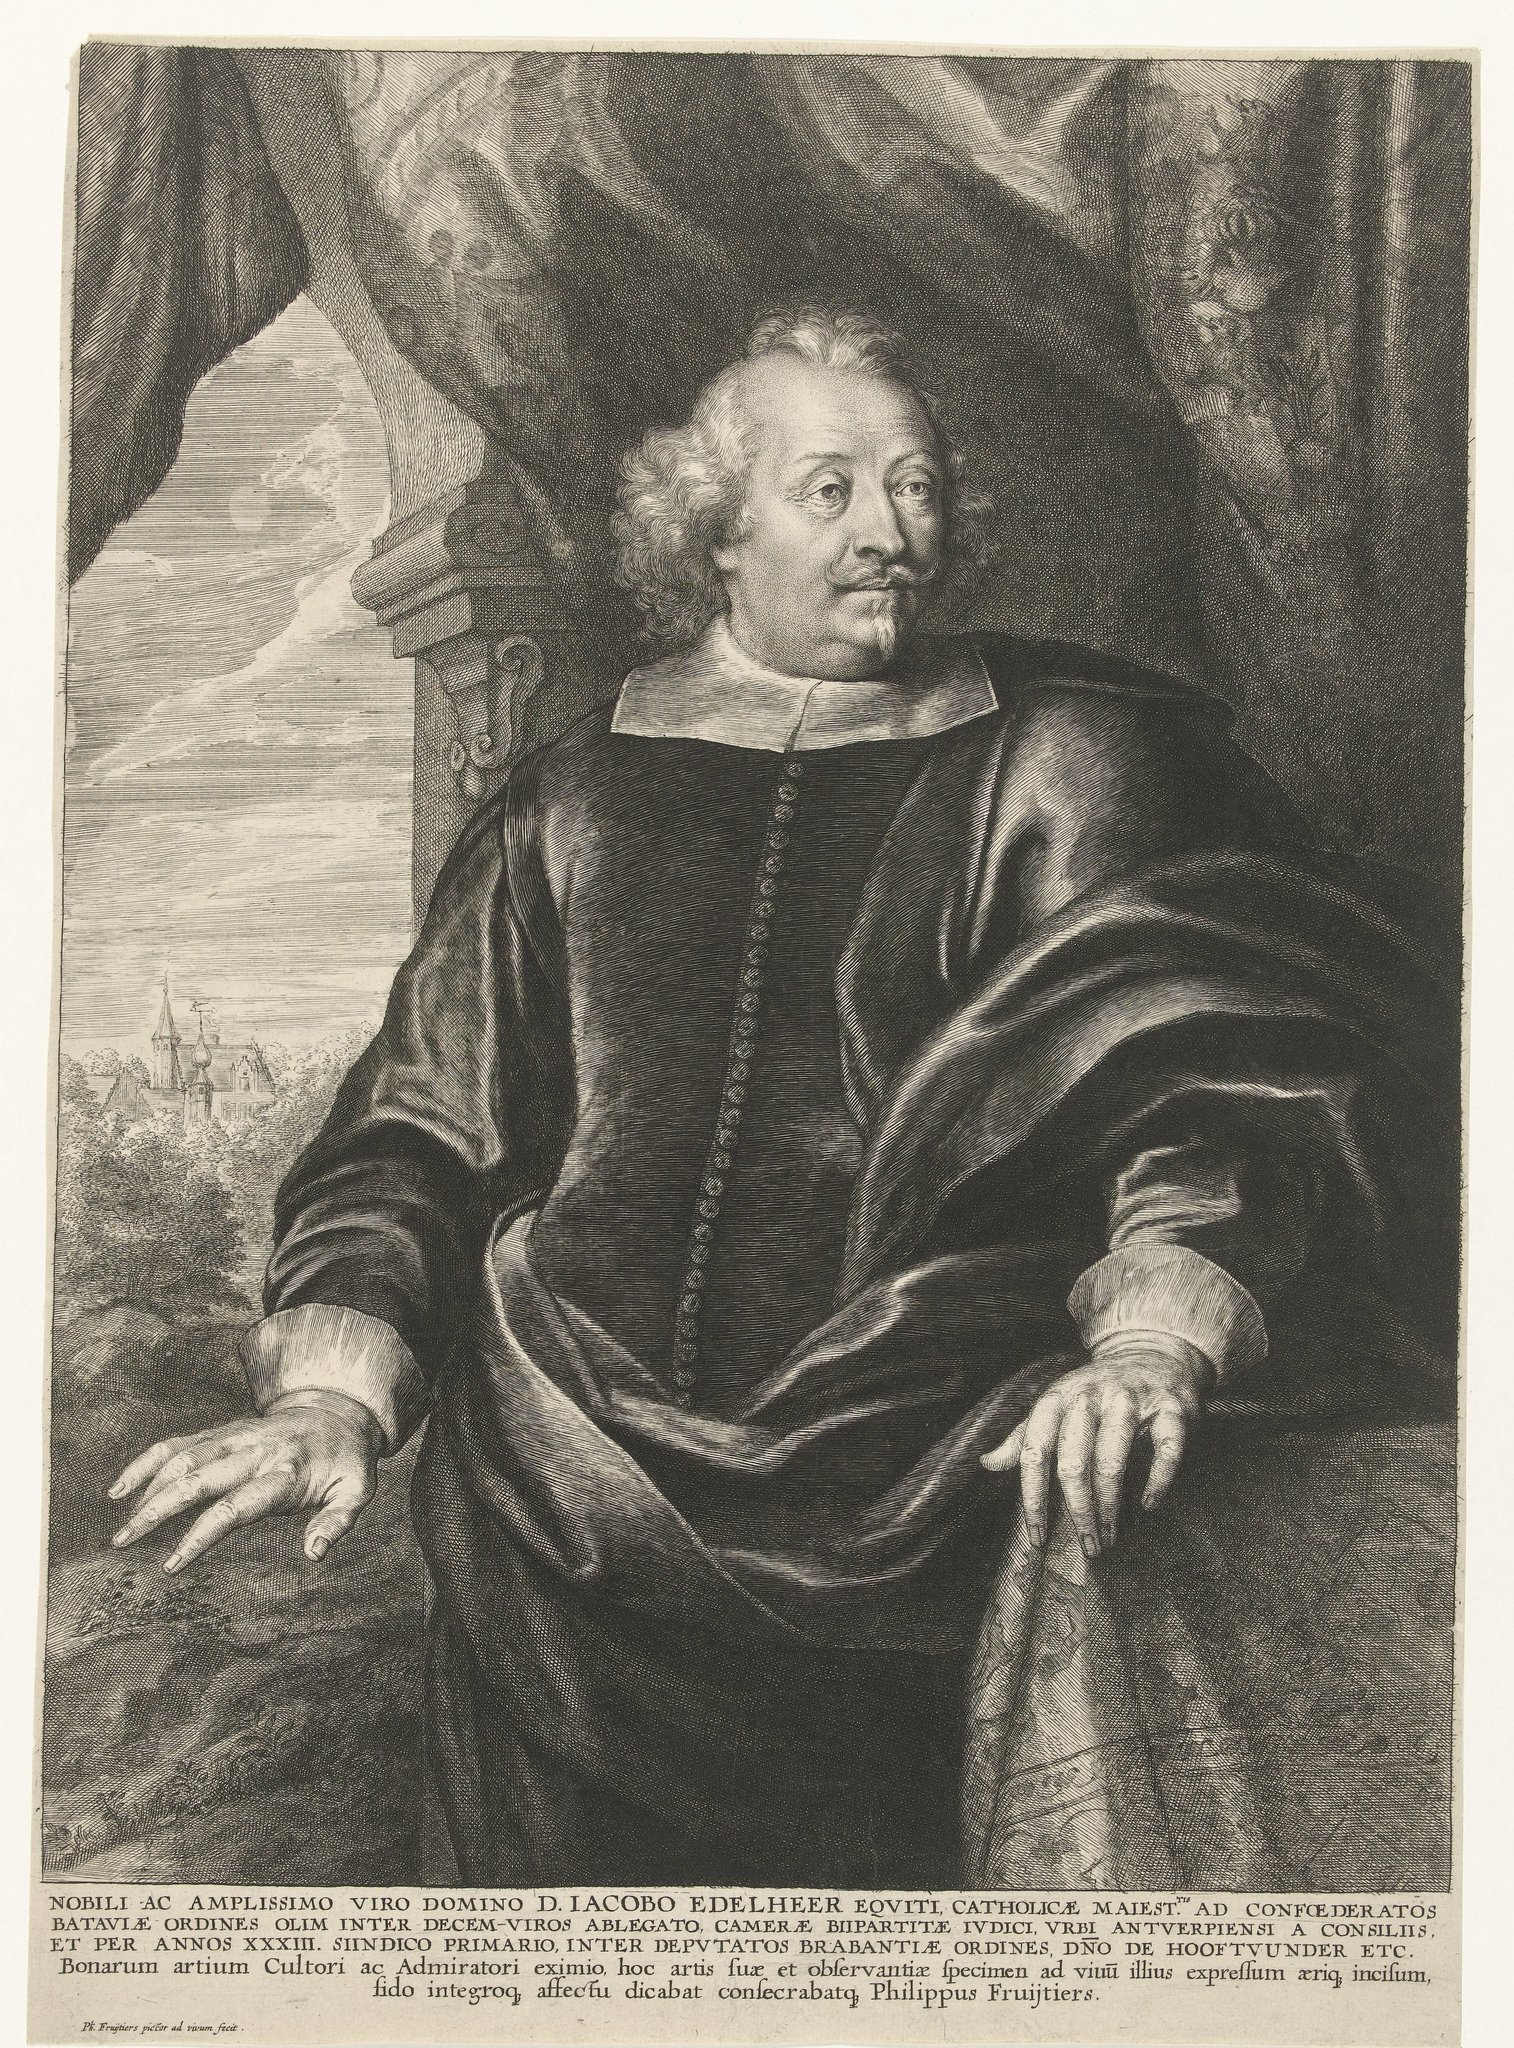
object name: print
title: Portret van Jacobus Edelheer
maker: philip fruytiers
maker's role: print maker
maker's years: 1610-1666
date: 1620-1666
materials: paper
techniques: etching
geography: antwerp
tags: louvain, politician, jacobus edelheer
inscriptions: collector's mark: Lugt 2228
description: De jurist en schrijver Jacobus Edelheer, staand naast een tafel, voor een draperie. In de marge een vijfregelige tekst in het Latijn.